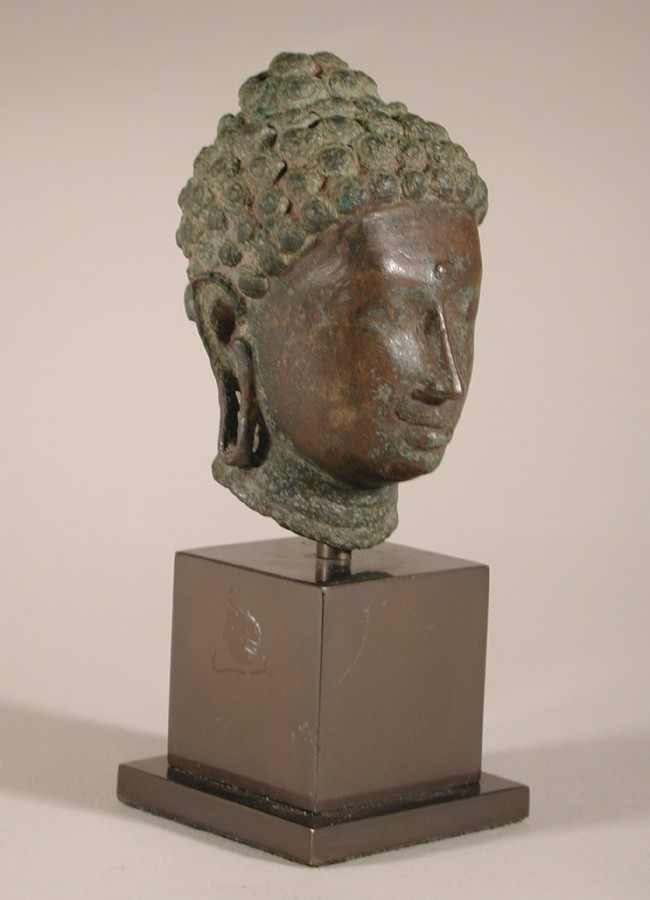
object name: head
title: Head of a Buddha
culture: indonesian, javanese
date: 501-700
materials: bronze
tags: heads,buddhism,buddha